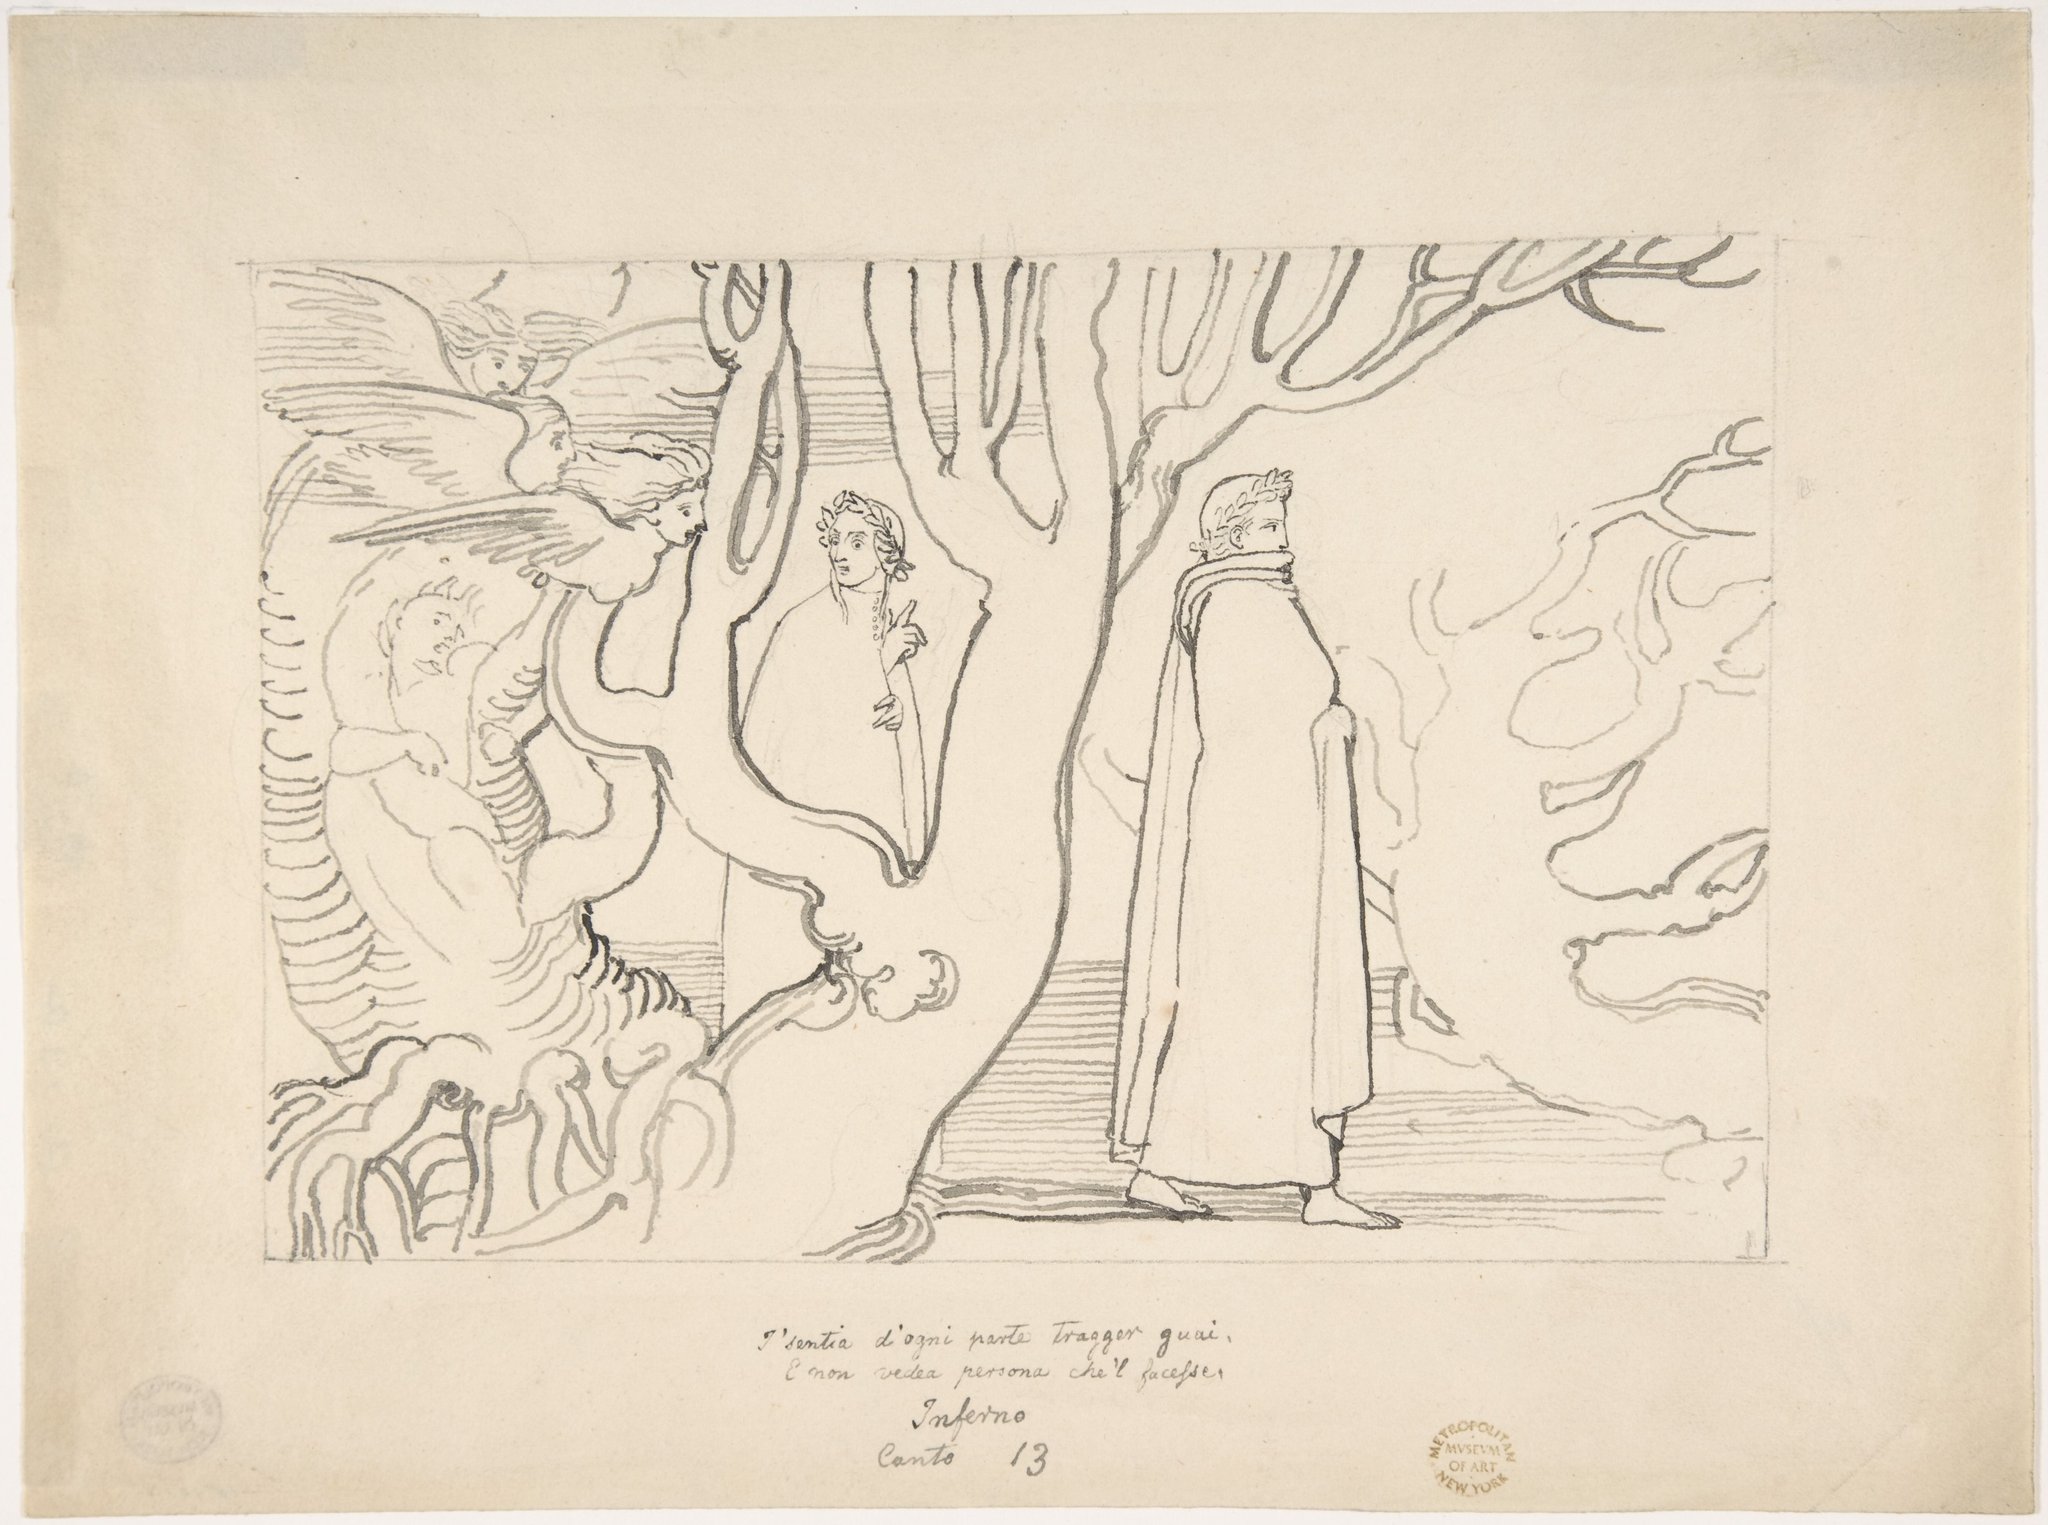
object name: drawing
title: Dante and Virgil in the Suicidal Wood (Inferno, Canto 13, verses 22-23)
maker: john flaxman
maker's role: artist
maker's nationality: british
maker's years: 1755-1826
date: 1792-1793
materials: graphite, ink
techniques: pen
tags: men